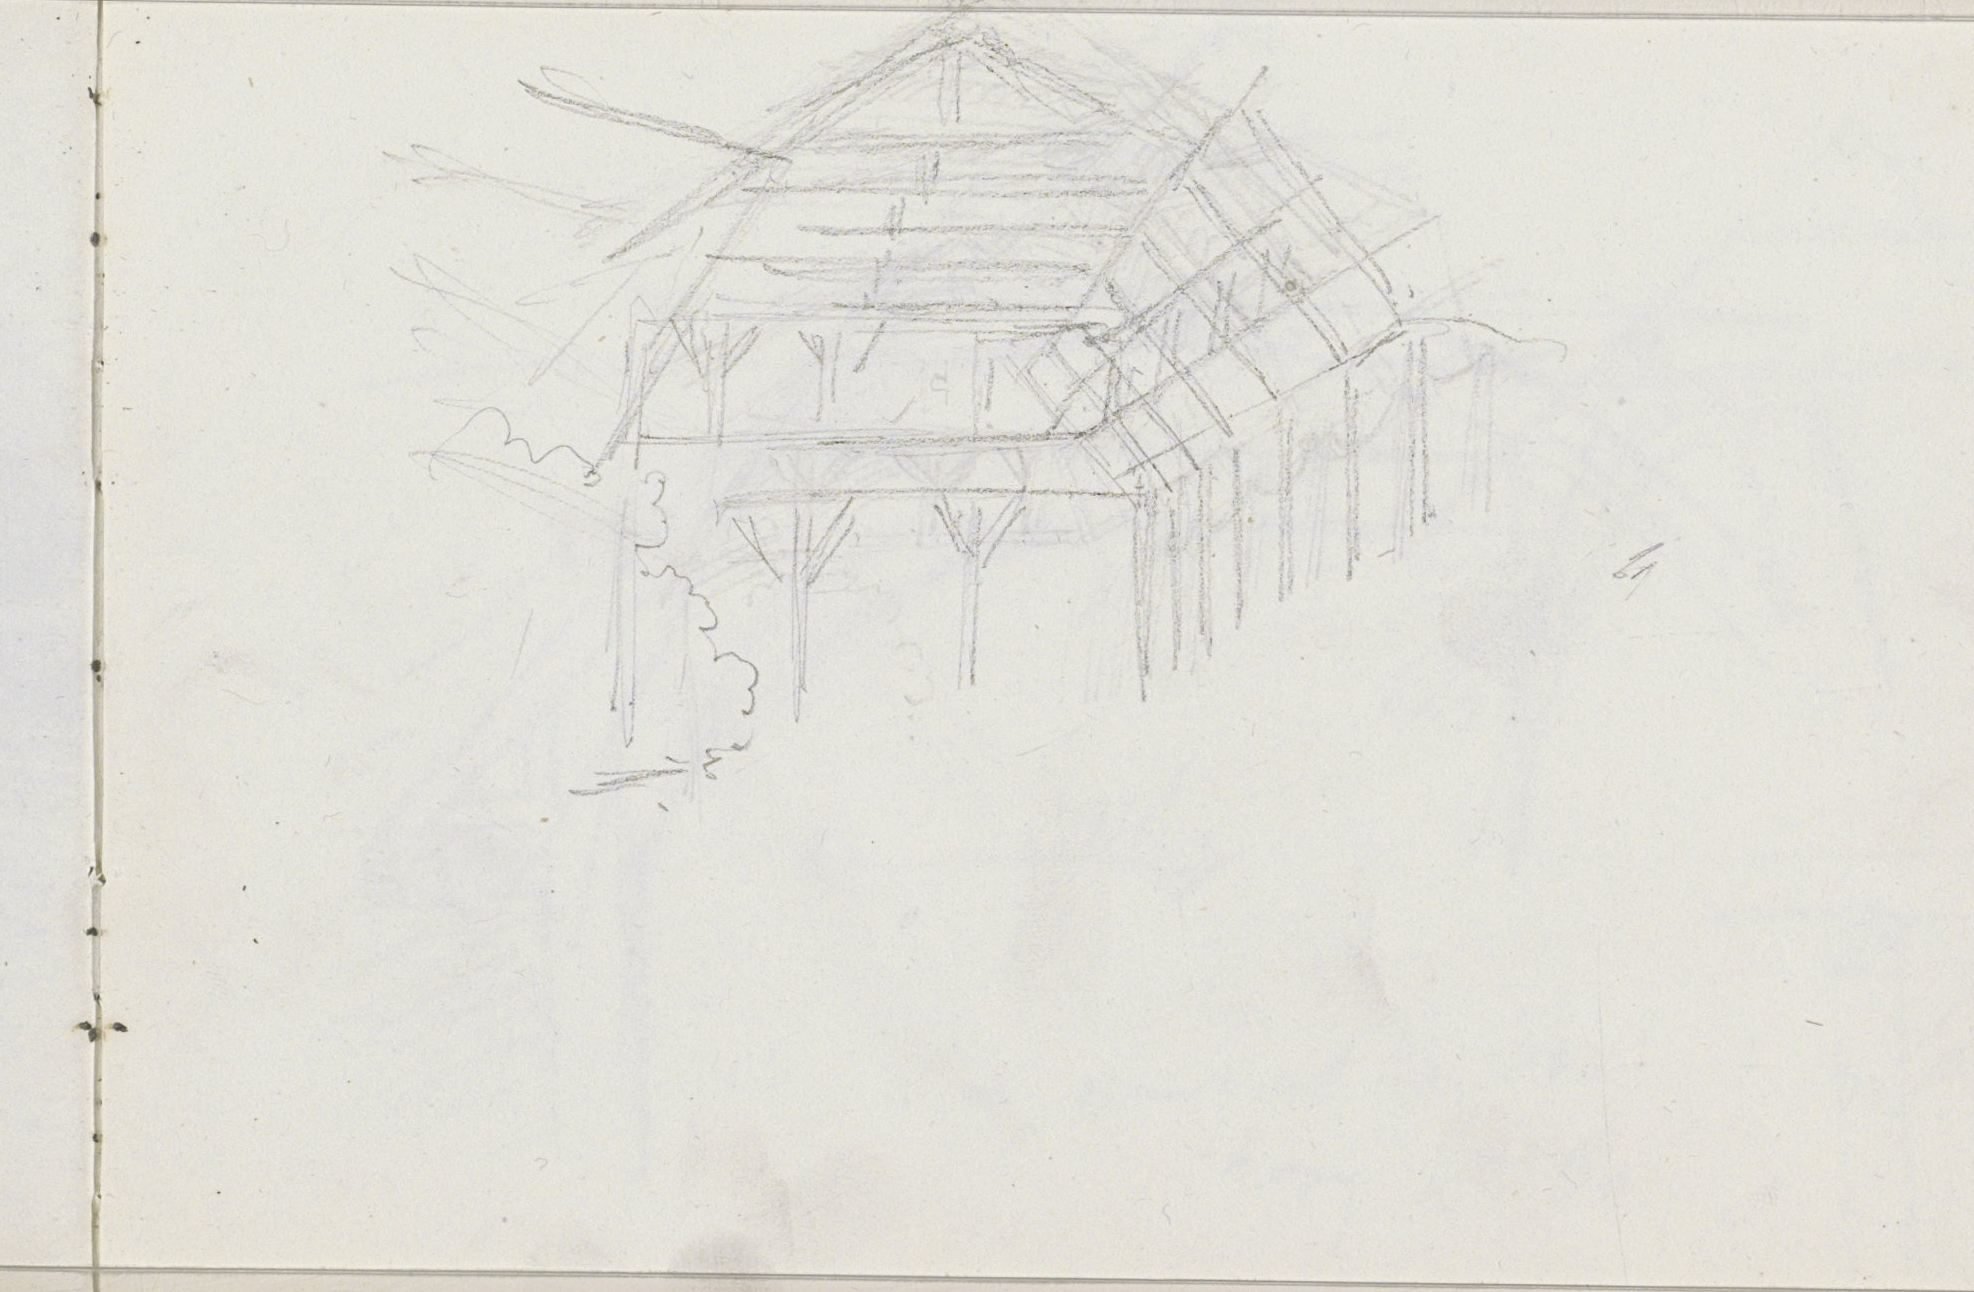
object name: sketchbook leaf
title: Constructie van houten balken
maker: isaac gosschalk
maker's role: draughtsman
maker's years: 1838-1907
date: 1860-1861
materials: paper, pencil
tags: wood, timber ~ building material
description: Blad 20 recto uit een schetsboek met 29 bladen.